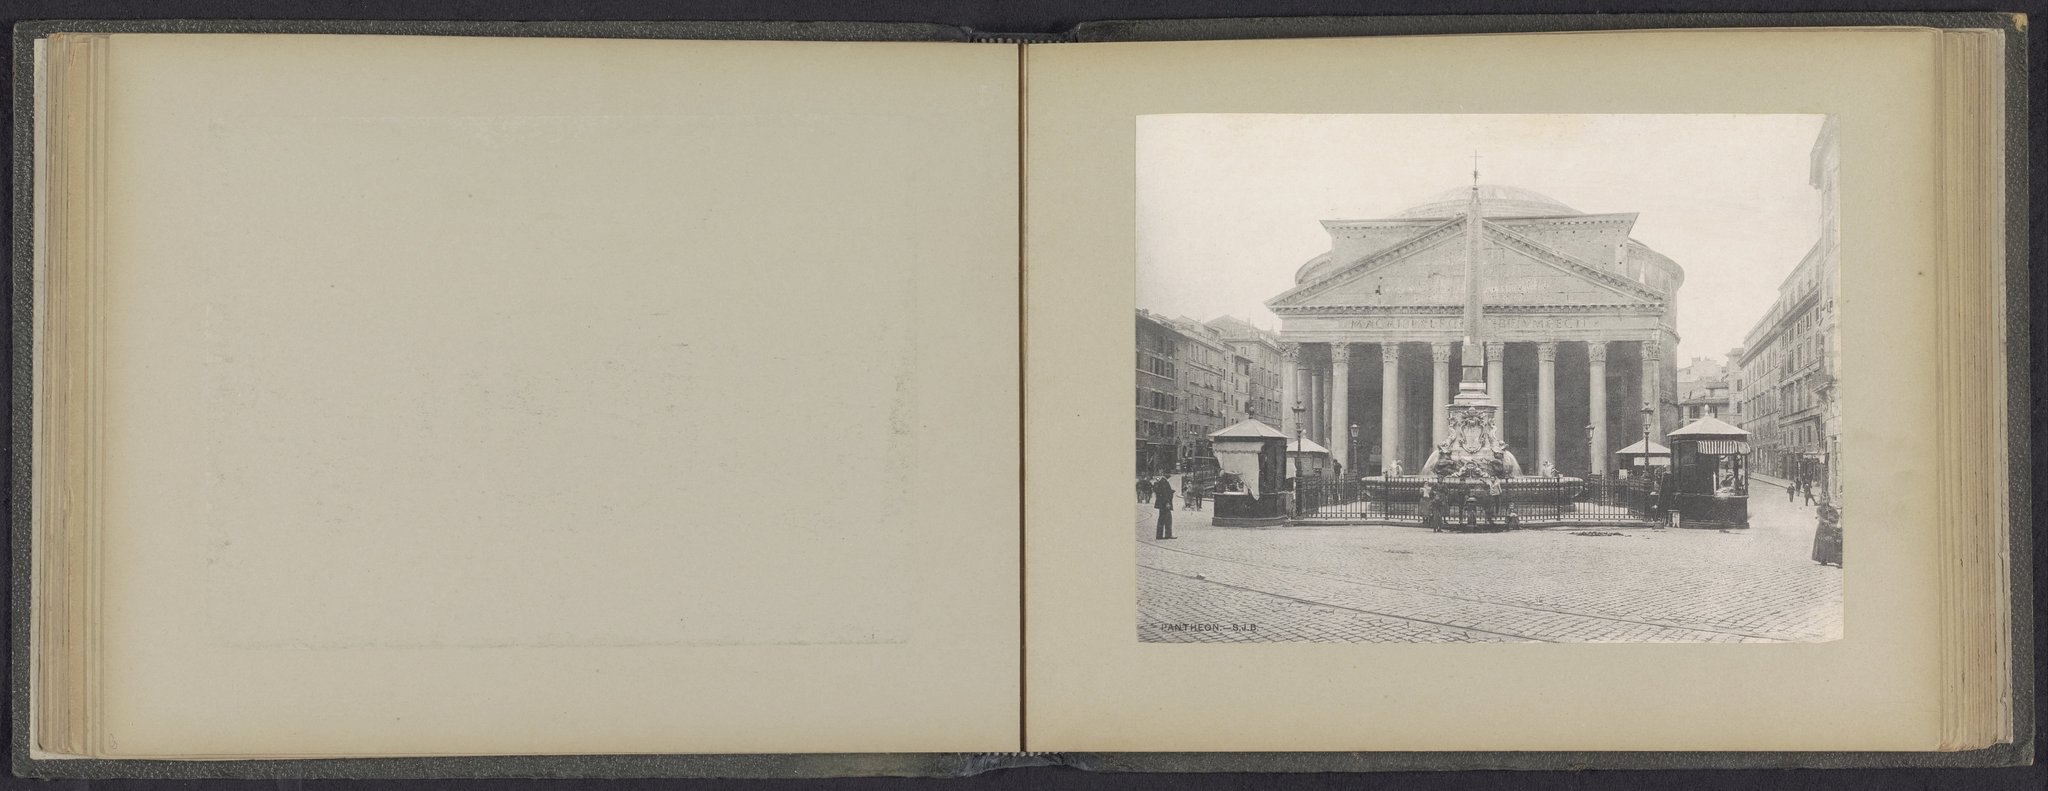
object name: page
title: Pantheon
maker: samuel j. beckett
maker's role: fotograaf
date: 1890-1900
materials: paper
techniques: photograph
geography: piazza della rotonda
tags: church (exterior), façade (of house or building)